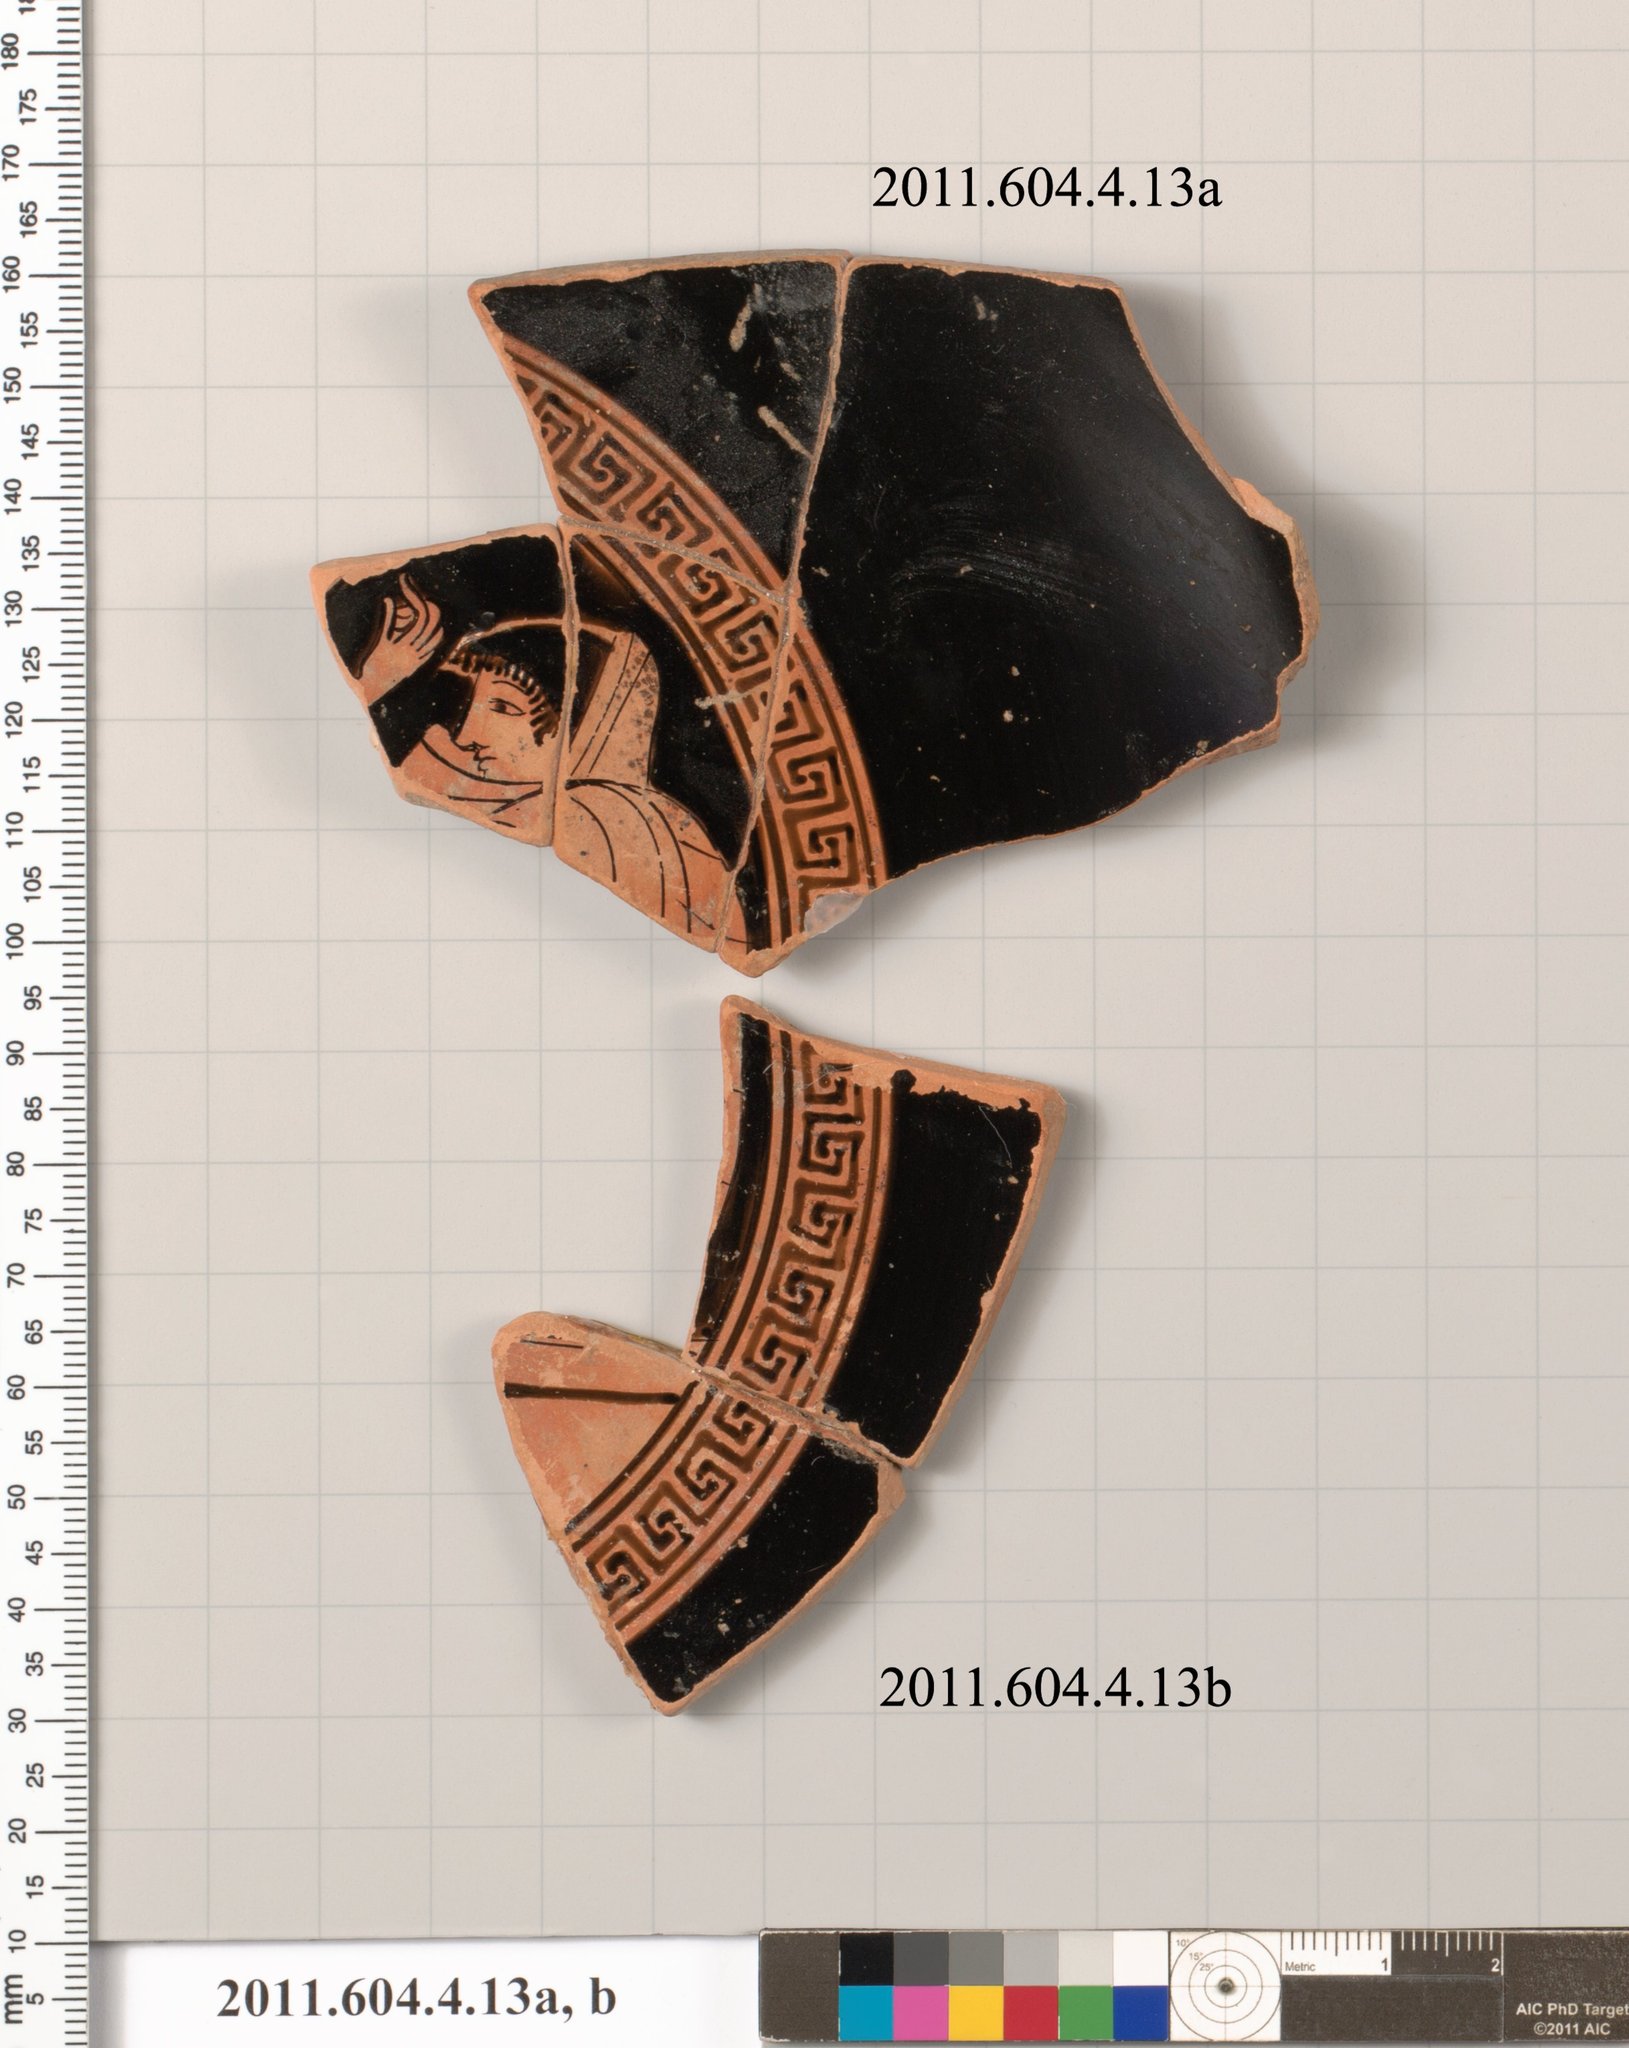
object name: kylix fragment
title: Terracotta fragments of a kylix (drinking cup)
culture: greek, attic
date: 500-451 BCE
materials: terracotta